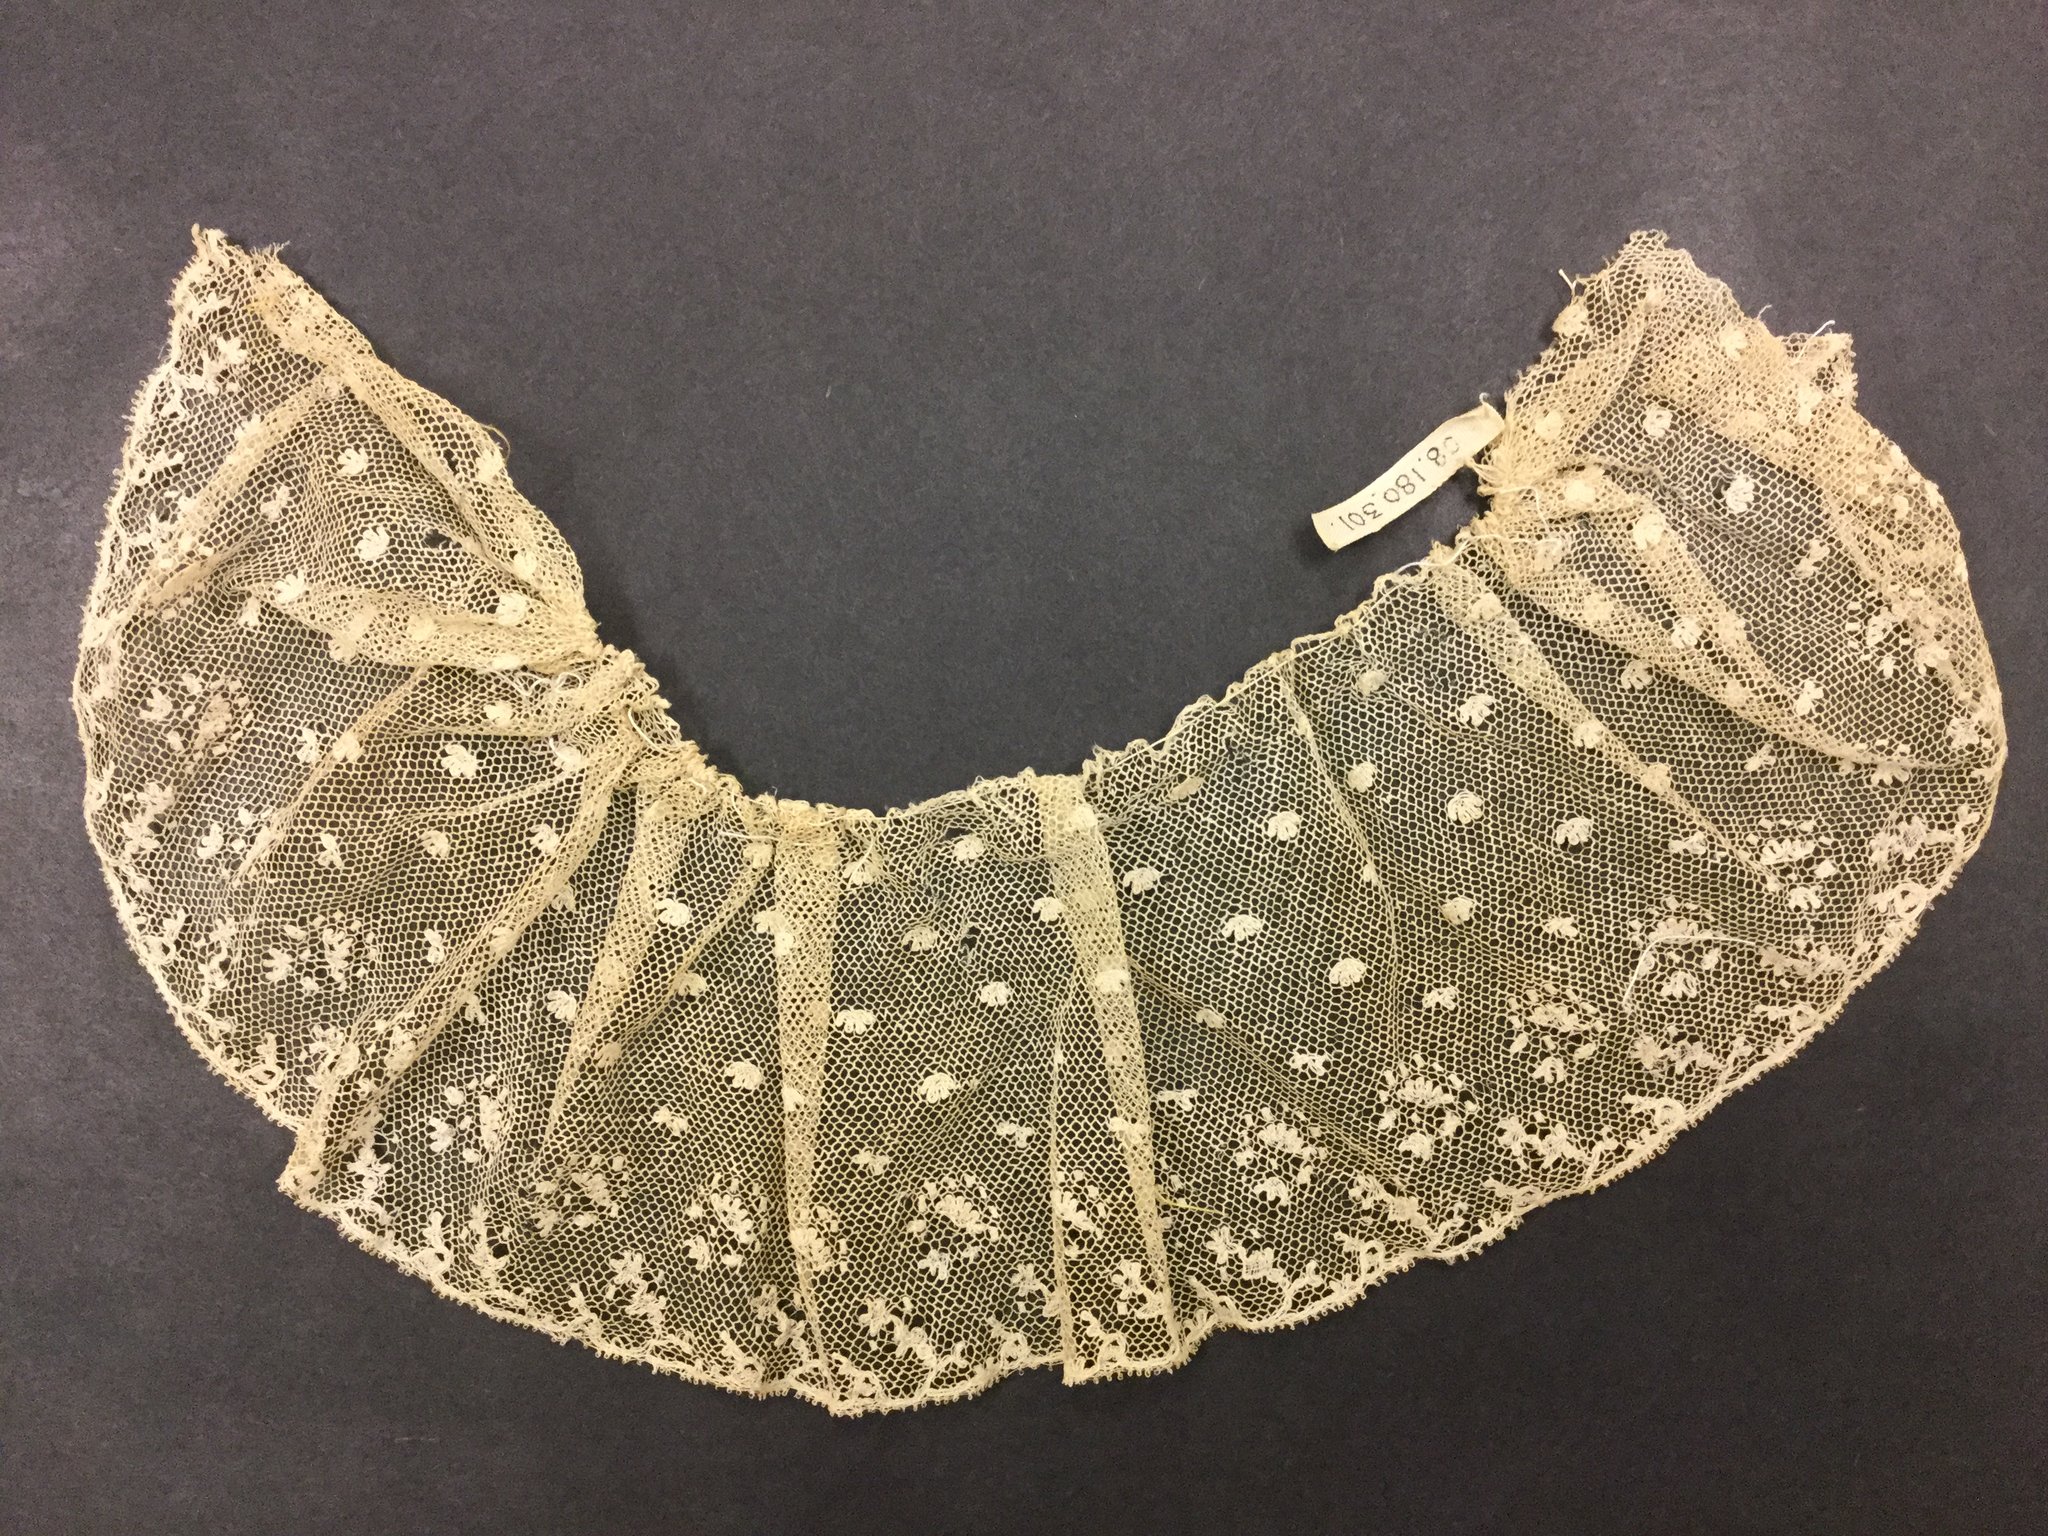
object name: piece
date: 1801-1900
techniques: lace